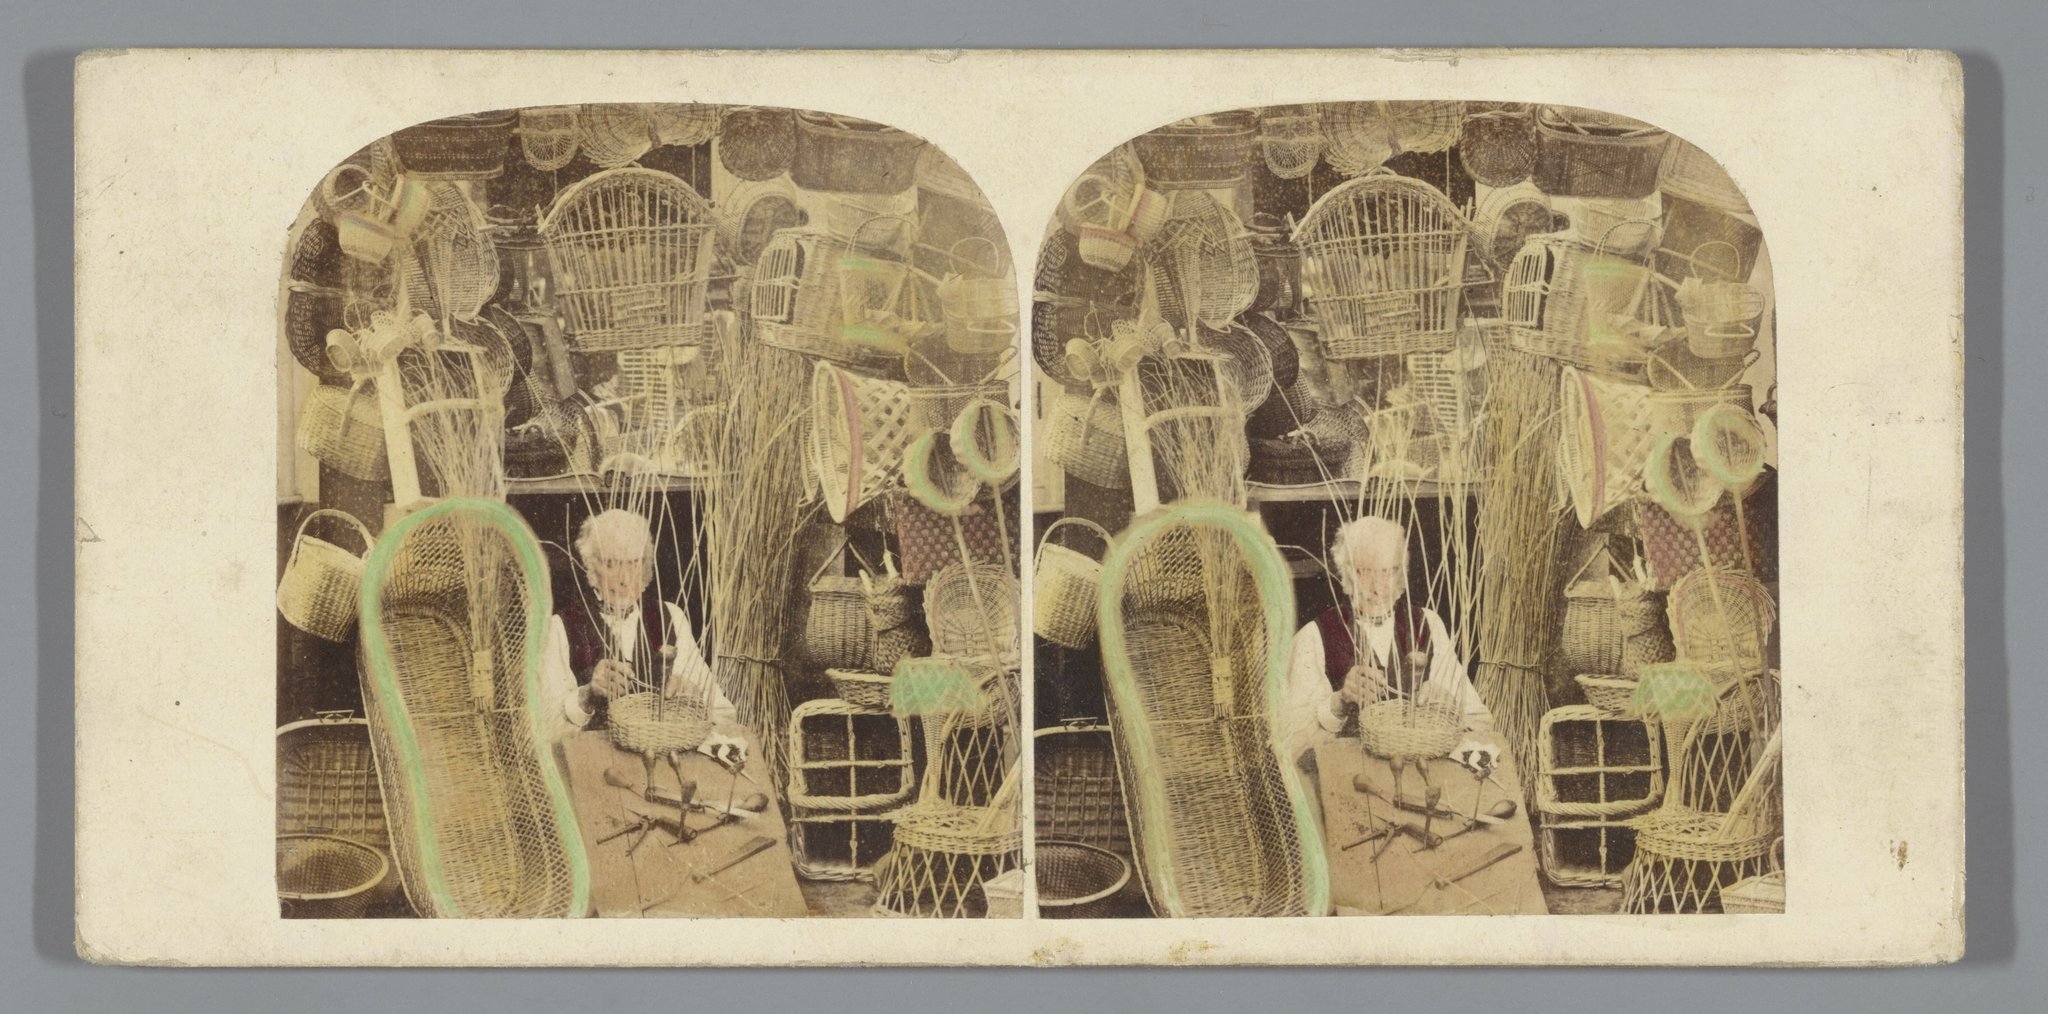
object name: stereograph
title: The Brighton Fancy Basket Maker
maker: Anonymous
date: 1852-1863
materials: cardboard, paper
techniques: albumen print, hand coloring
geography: brighton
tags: craft-production, skilled handiwork, container made of plant material other than wood: basket